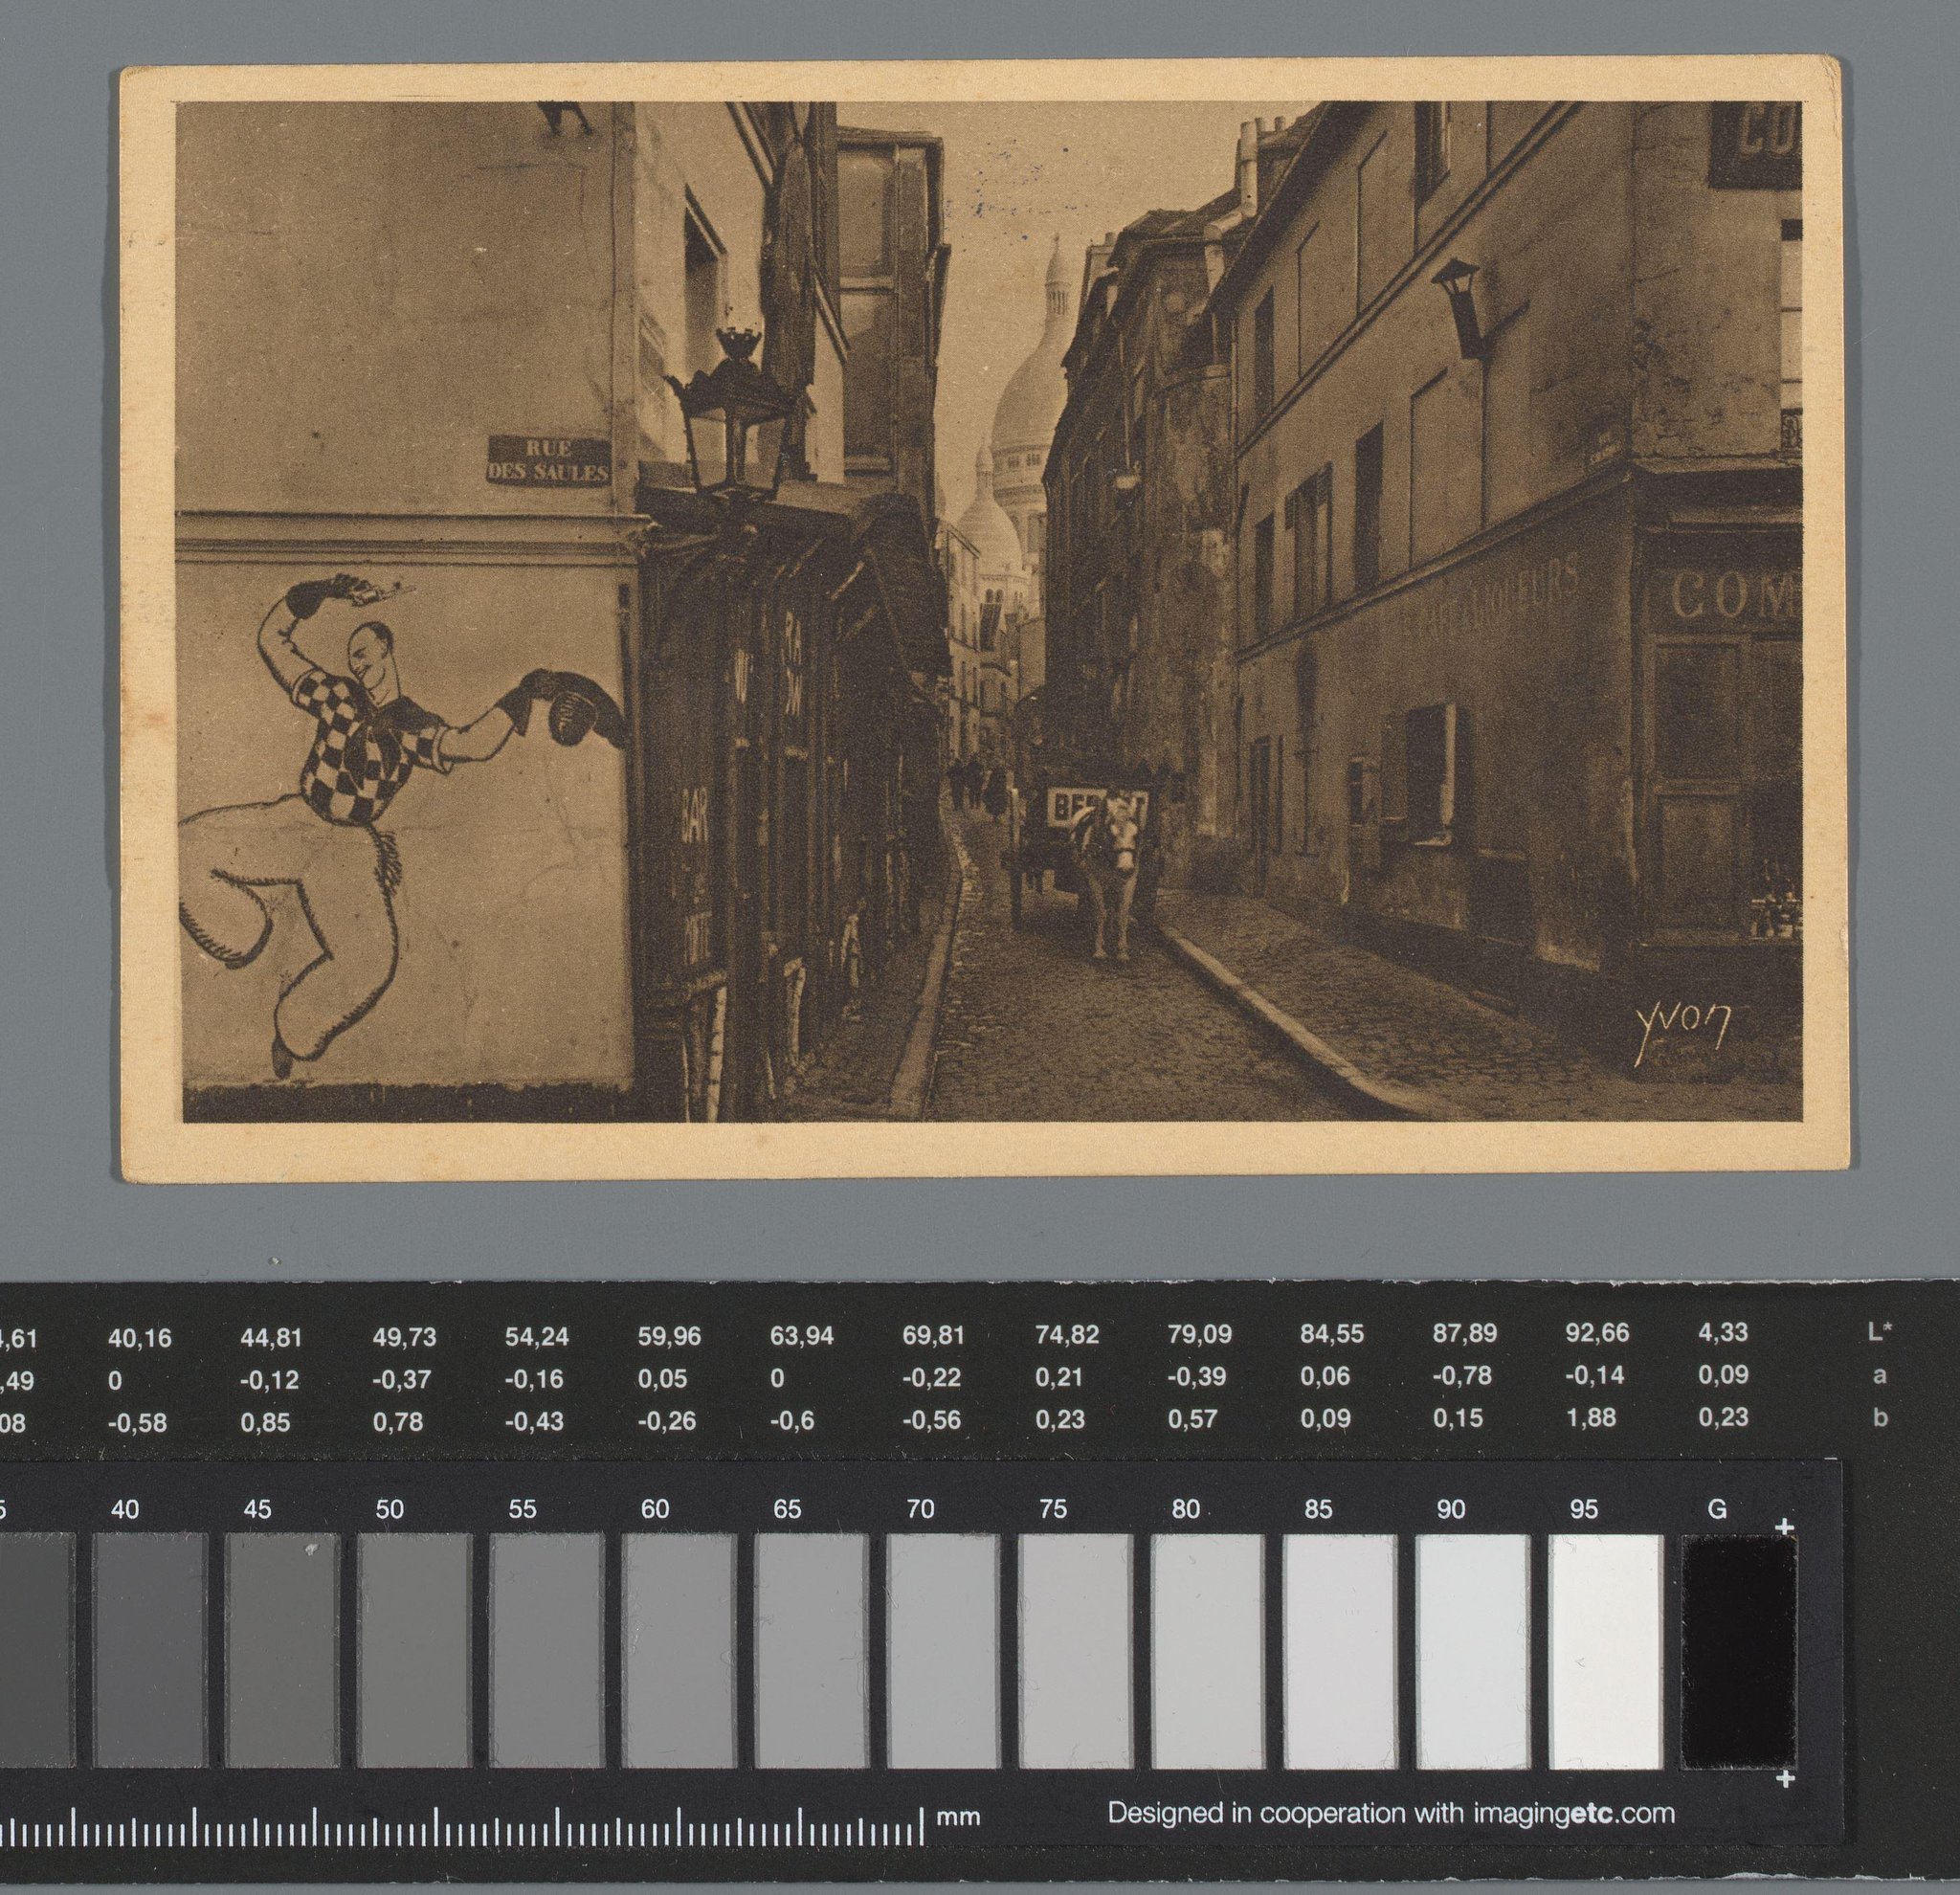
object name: ansichtkaart, prentbriefkaart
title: Prentbriefkaart aan Jan Ponstijn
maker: leo gestel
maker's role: draughtsman, print maker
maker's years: 1881-1941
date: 1926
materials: cardboard, ink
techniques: pen, rotogravure, writing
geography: paris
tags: jan petrus ponstijn, picture, painting, temporary exhibition, 'salon'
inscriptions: date